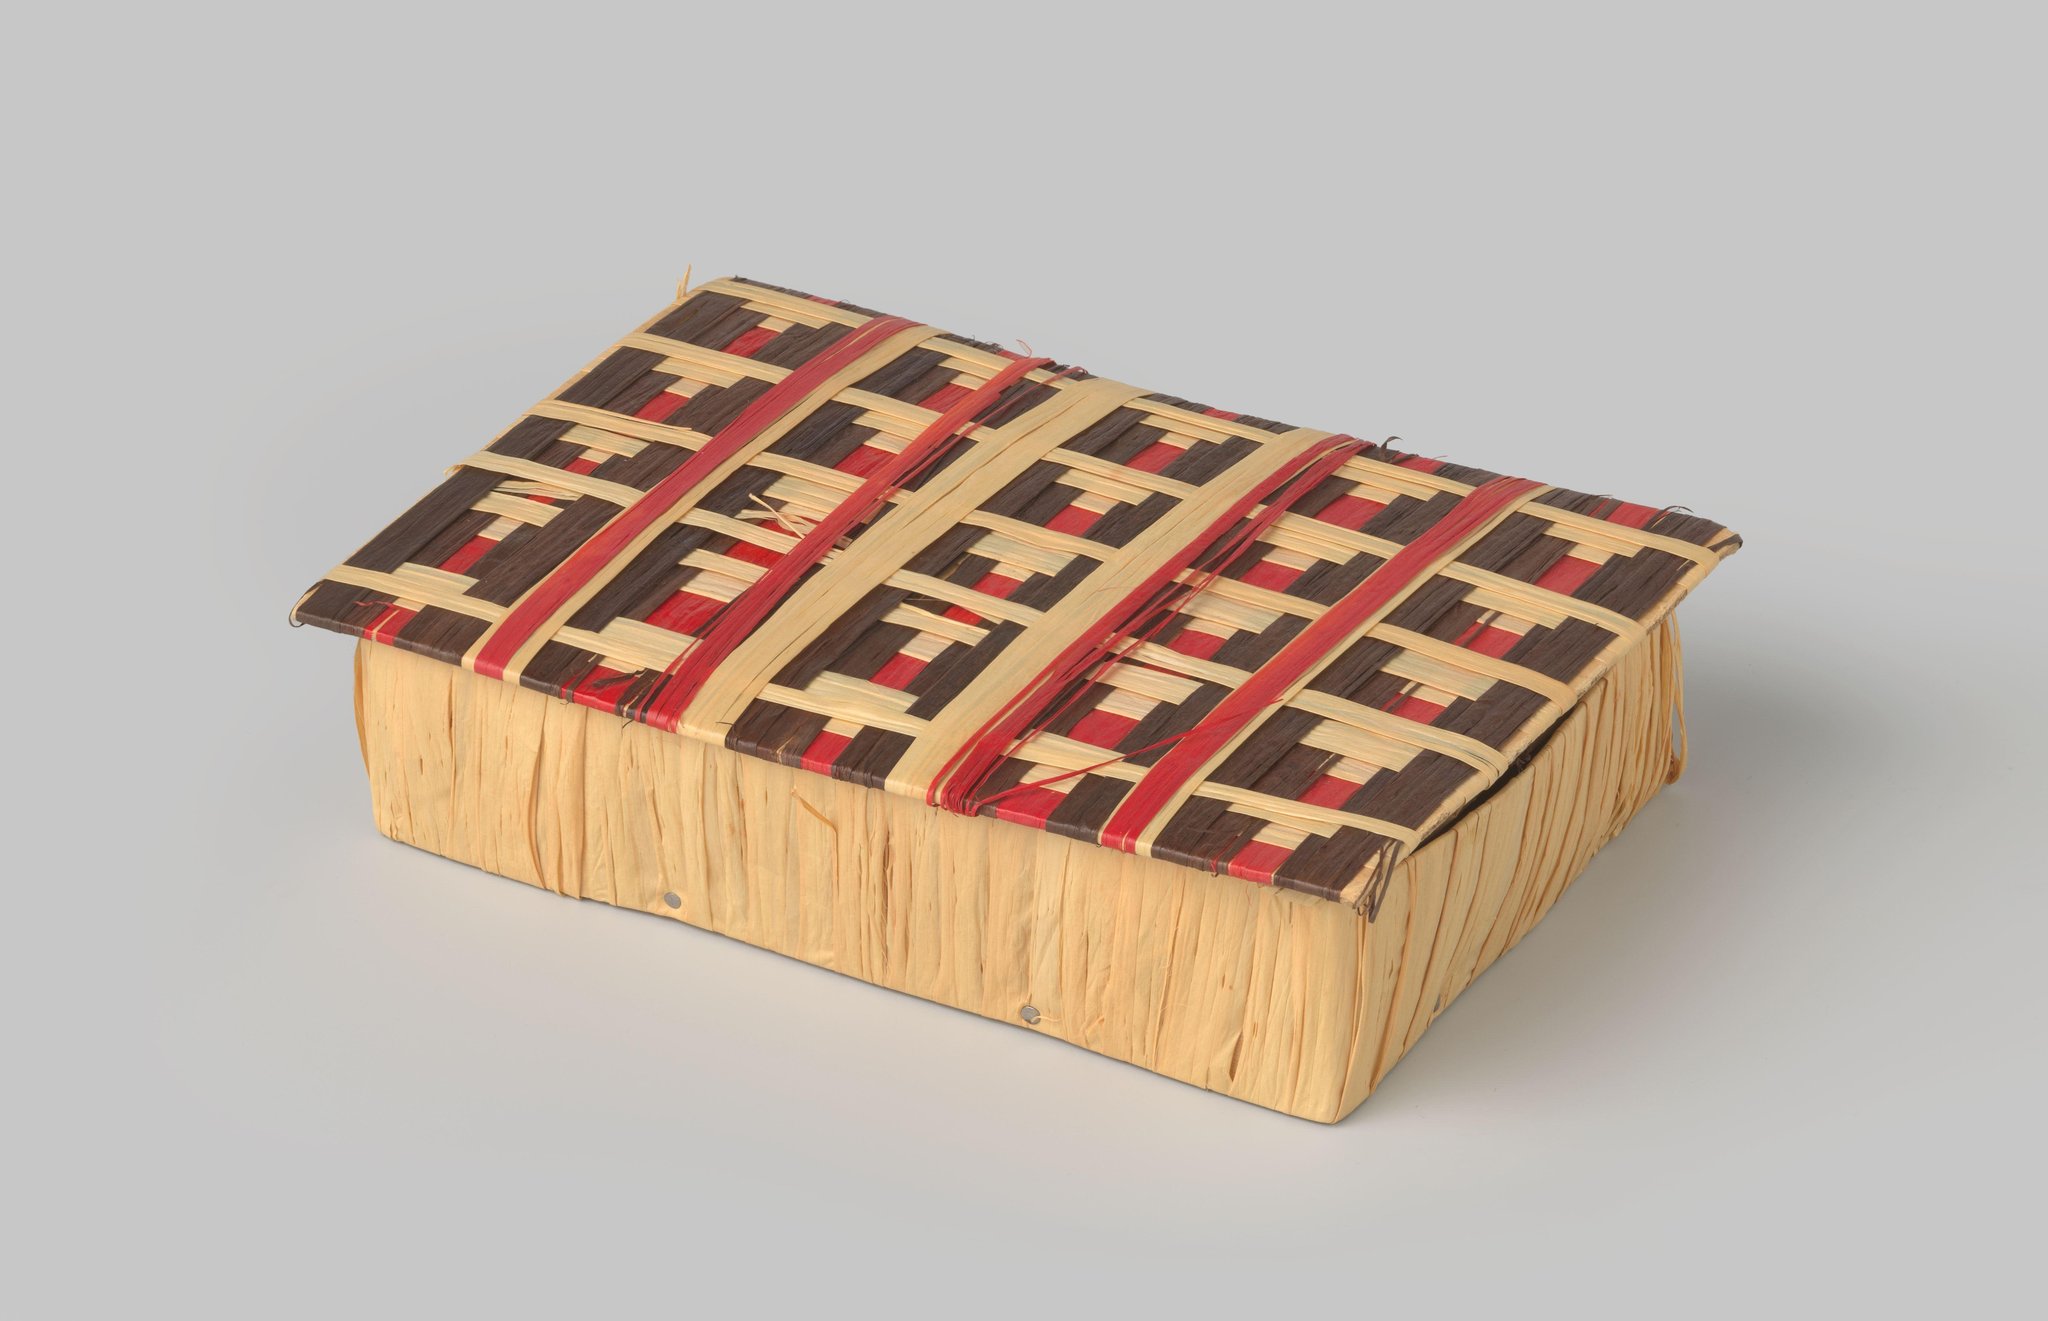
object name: box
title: Doos van hout, overtrokken met raffia in rood, bruin en wit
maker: Anonymous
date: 1900-1925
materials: raffia, wood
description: Dit object is onderdeel van de nalatenschap van Isabel Elon-Wachenheimer (1928-2010). Tot haar overlijden behoorde het samen met de andere objecten uit de nalatenschap tot haar privédomein van Isabel Wachenheimer. In die particuliere context zijn deze objecten tezamen en individueel aandenkens - aan de jeugd, ouders en familie van Isabel Wachenheimer vóór en tijdens de Shoah en aan haar leven na de Tweede Wereldoorlog. Isabel Wachenheimer, die van juni 1943 tot mei 1945 gevangen zat in Kamp Westerbork, Theresienstadt, Auschwitz, Lenzing a/d Oberdonau (een buitenkamp van Mauthausen), overleefde de Shoah. Haar ouders – Eugène Wachenheimer en Else Wachenheimer-Moos - werden op 14 oktober 1944 in Auschwitz-Birkenau vermoord.